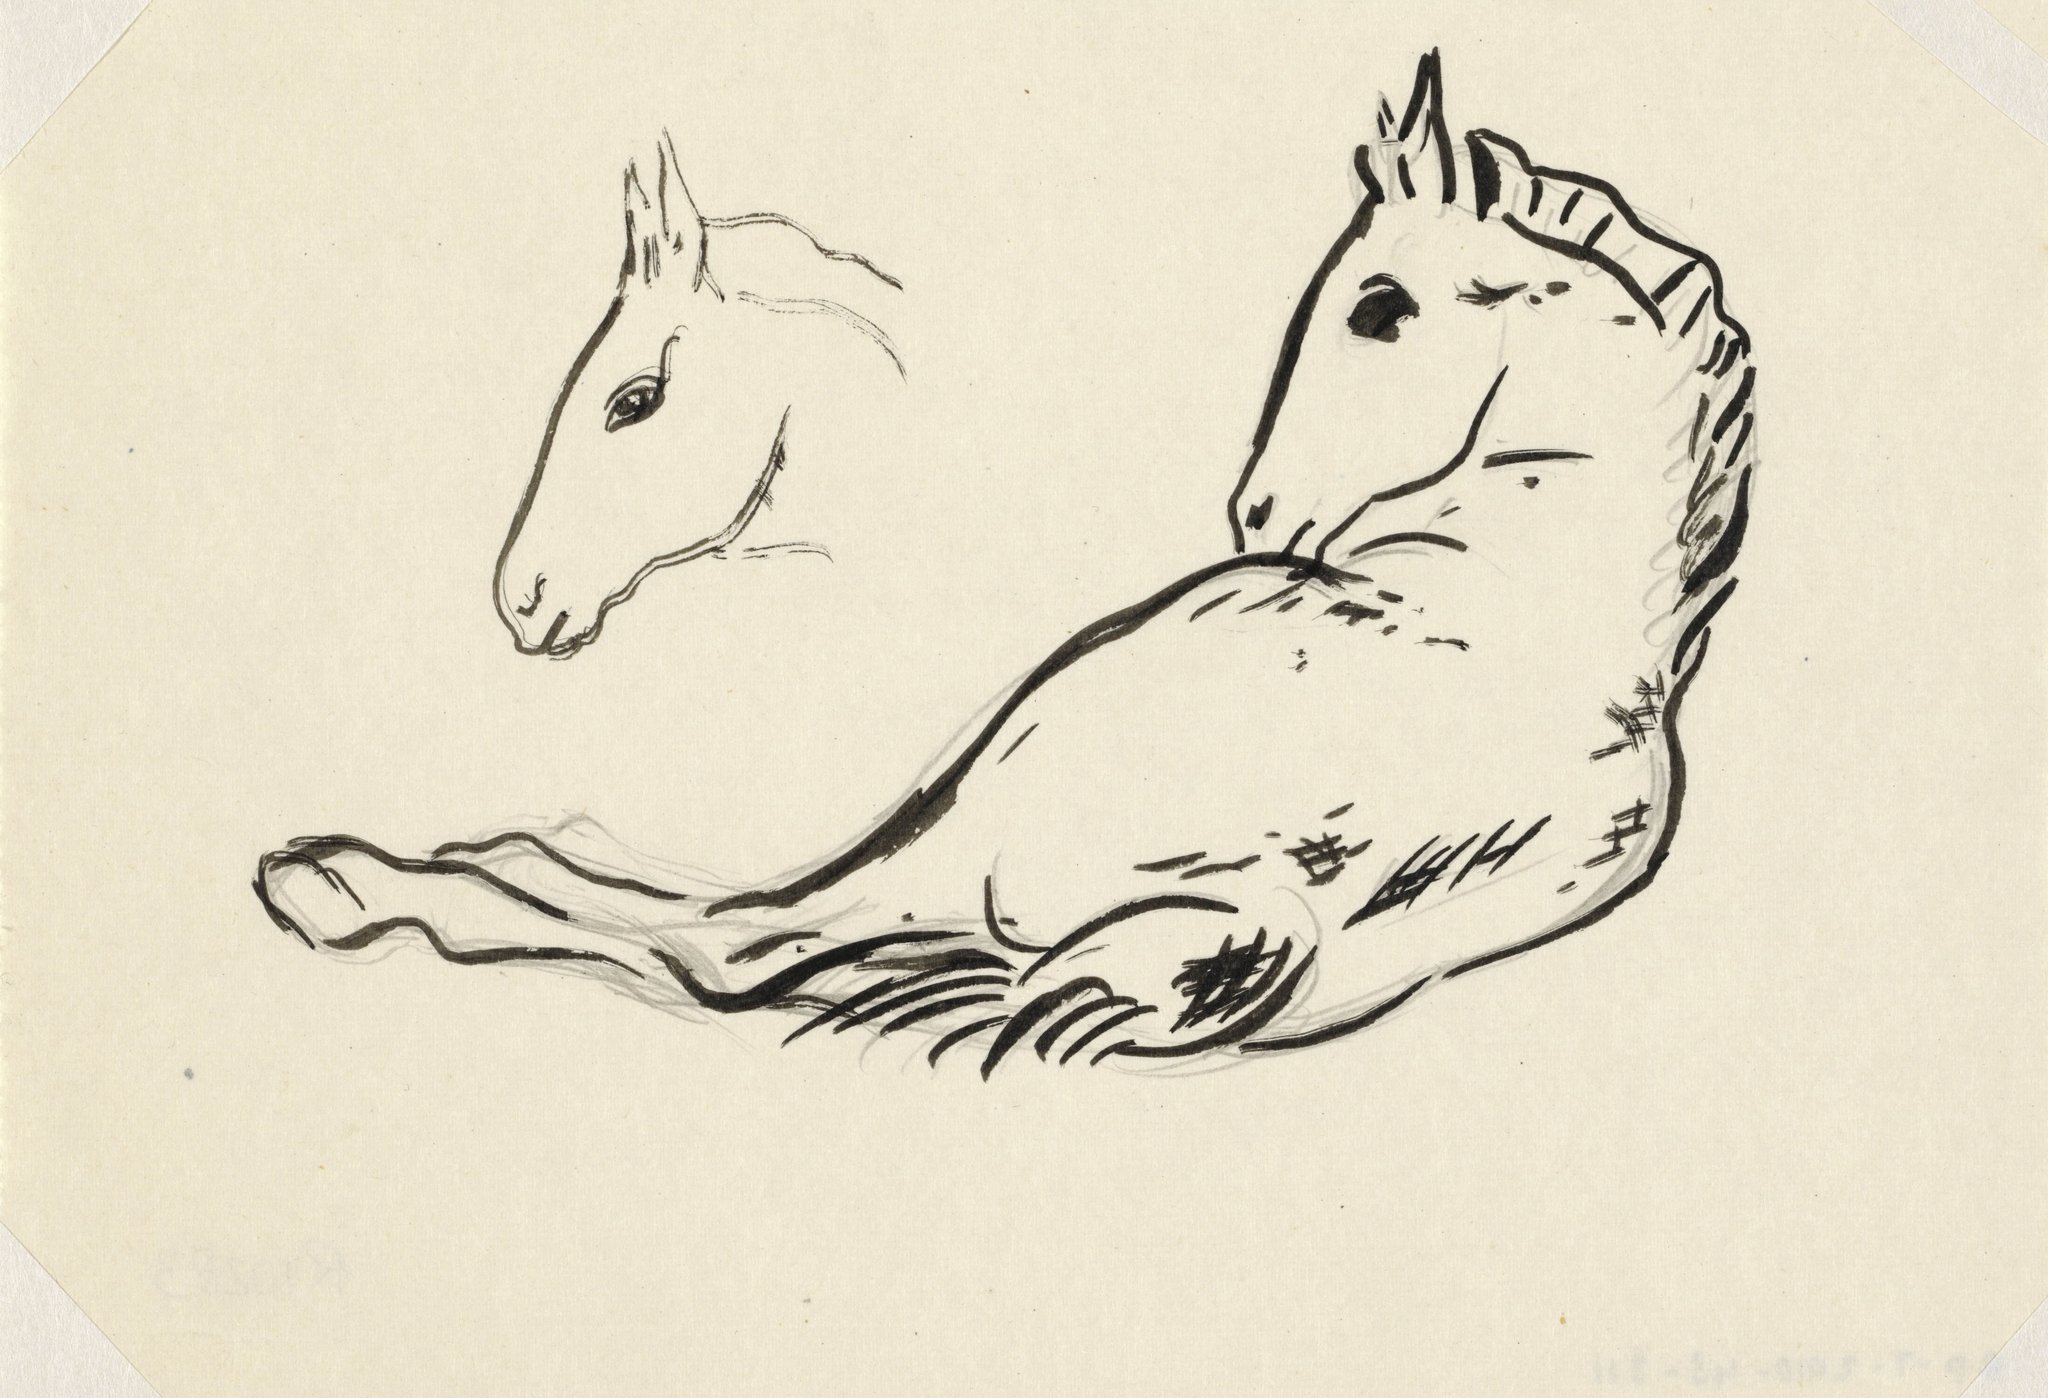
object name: drawing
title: Zonder titel (twee schetsen liggend veulen)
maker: leo gestel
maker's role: draughtsman, print maker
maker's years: 1881-1941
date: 1935-1936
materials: ink, paper, pencil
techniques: brush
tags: horse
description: De huidige titels zijn door het museum toegekend bij gebrek aan informatie over een originele titel.